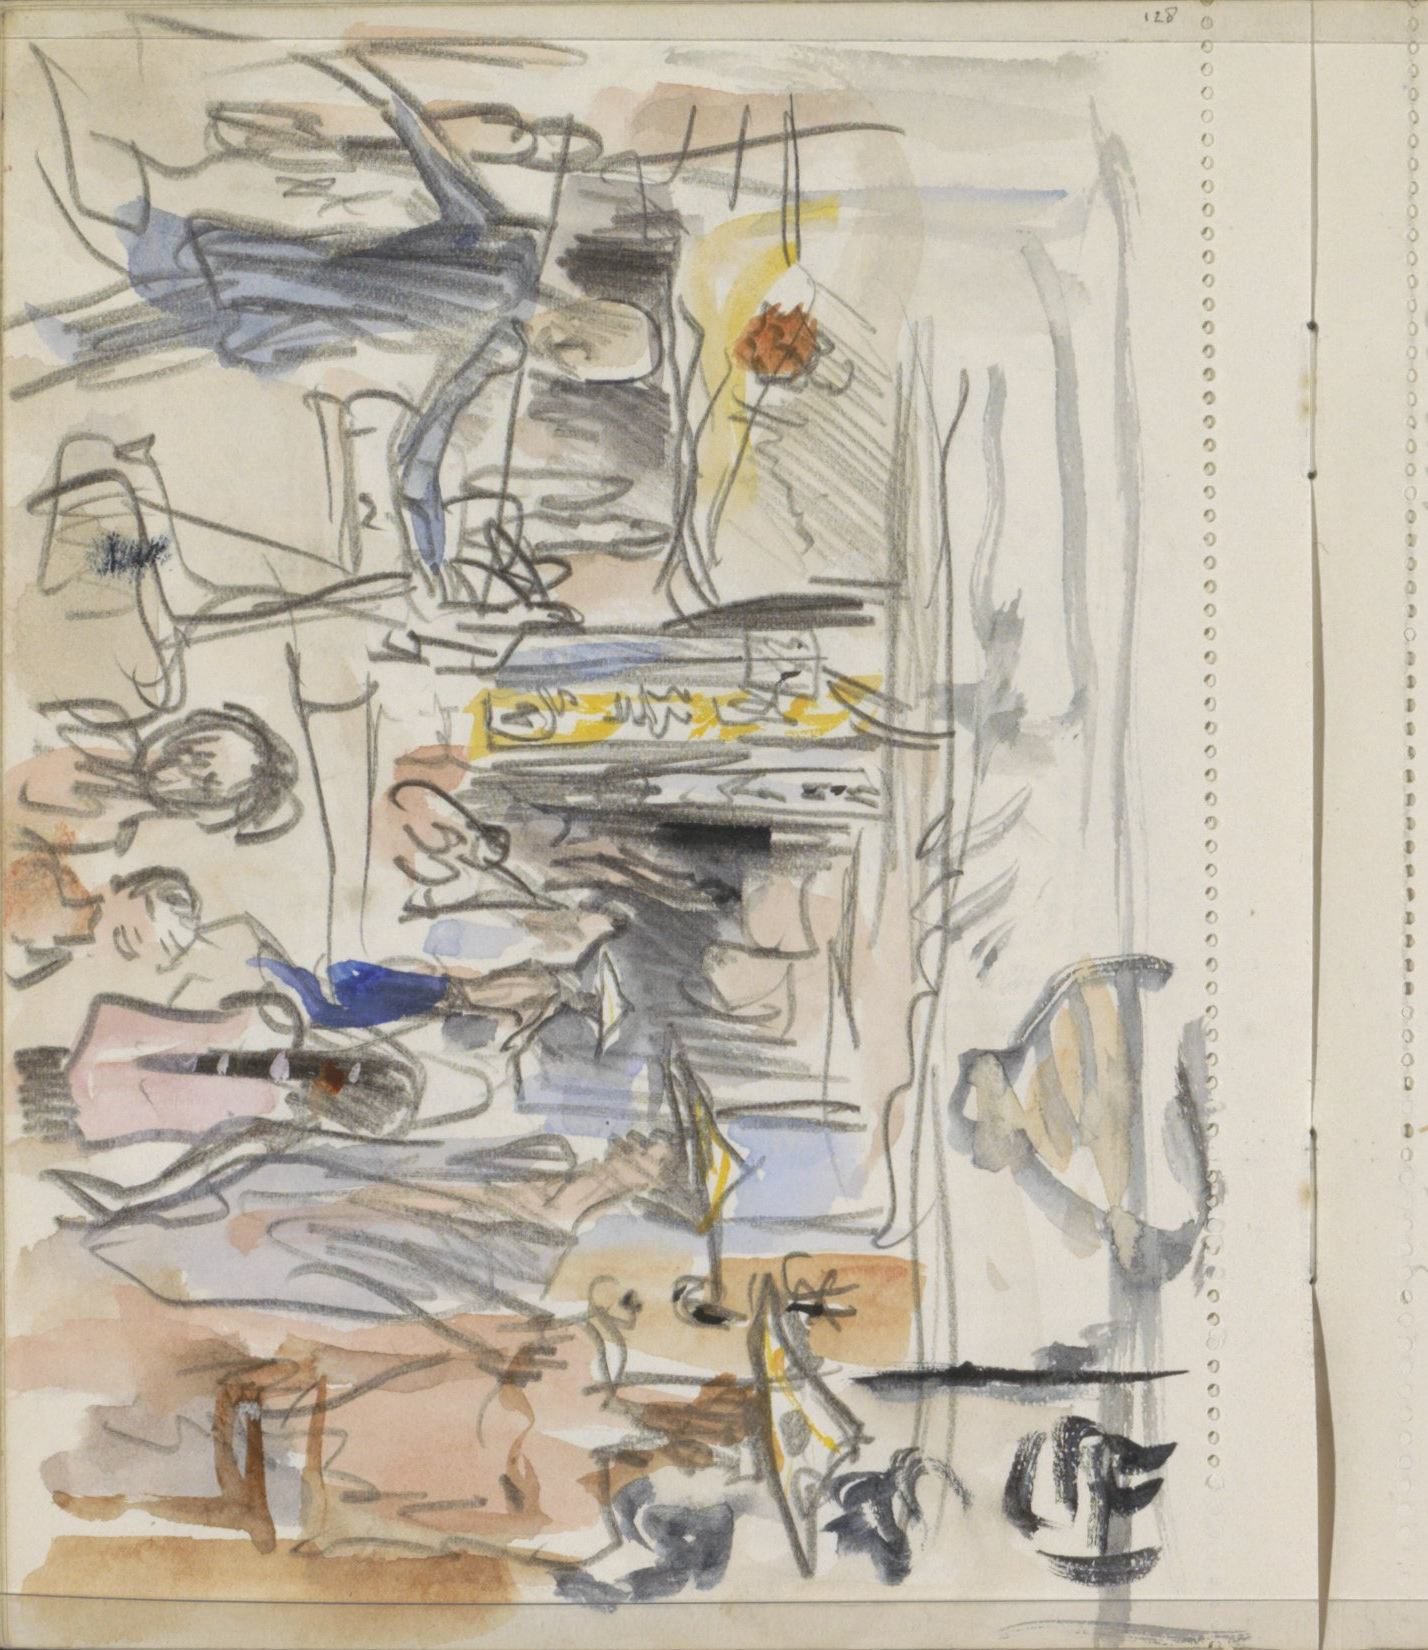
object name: sketchbook leaf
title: Straat met figuren en banieren met Chinese tekens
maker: marius bauer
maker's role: draughtsman, print maker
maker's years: 1867-1932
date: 1925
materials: chalk, paper, watercolor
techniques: brush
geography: indonesia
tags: asiatic races and peoples, carrying something, street (+ city(-scape) with figures, staffage)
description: Pagina 128 uit een schetsboek met 67 bladen.